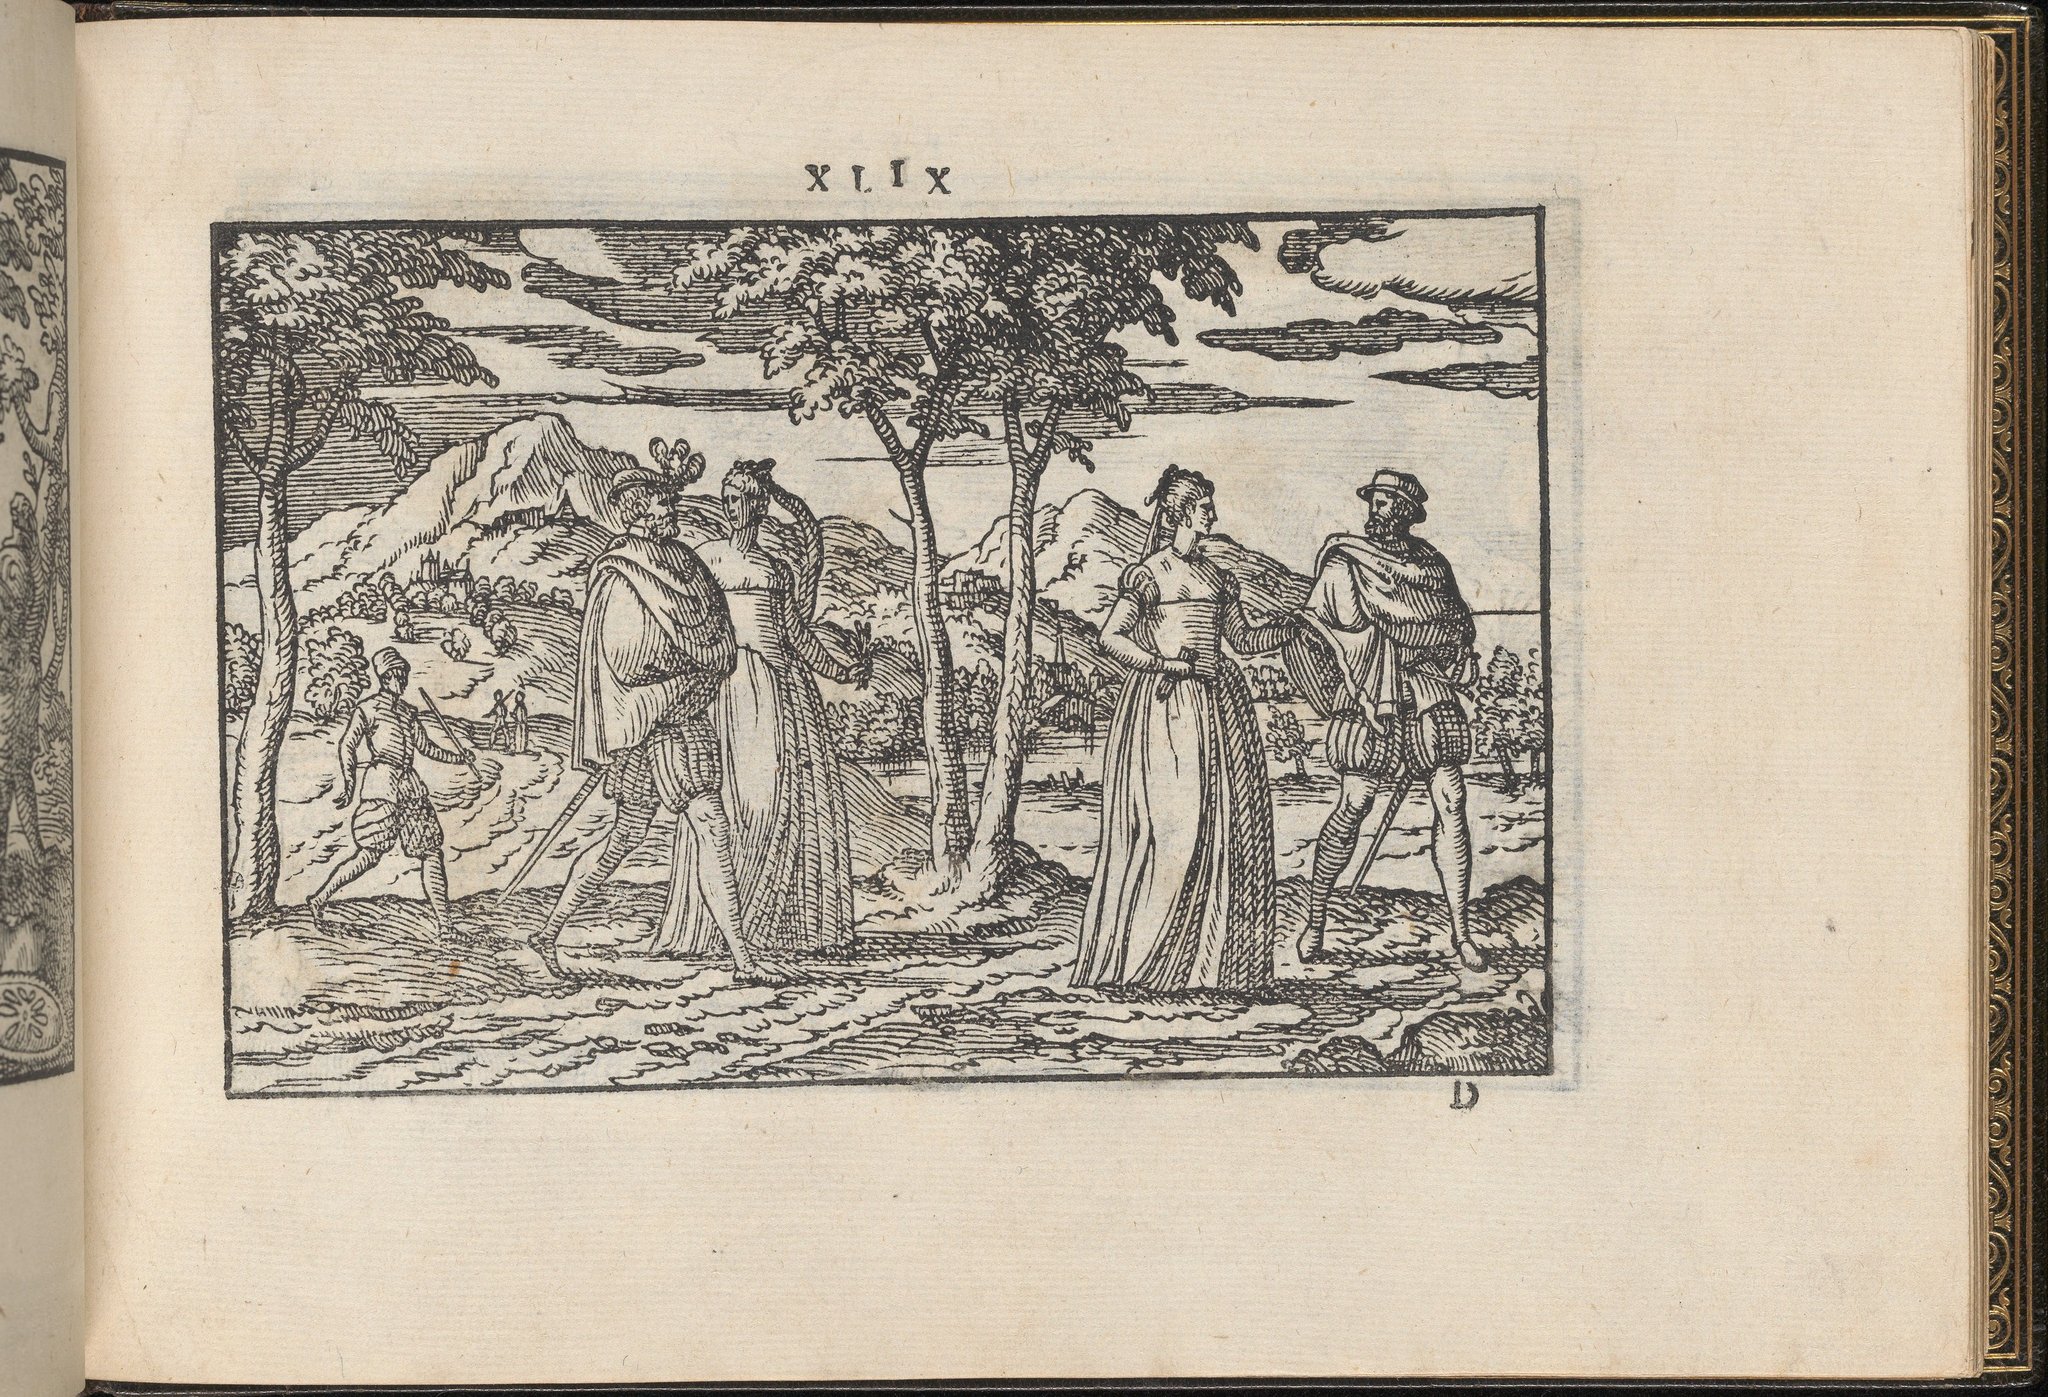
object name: book print ornament architecture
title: La Vera Perfettione del Disegno di varie sorti di recami, page 25 (recto)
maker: giovanni ostaus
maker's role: publisher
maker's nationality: italian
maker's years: 1507-1607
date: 1567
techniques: woodcut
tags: boys,couples,walking,mountains